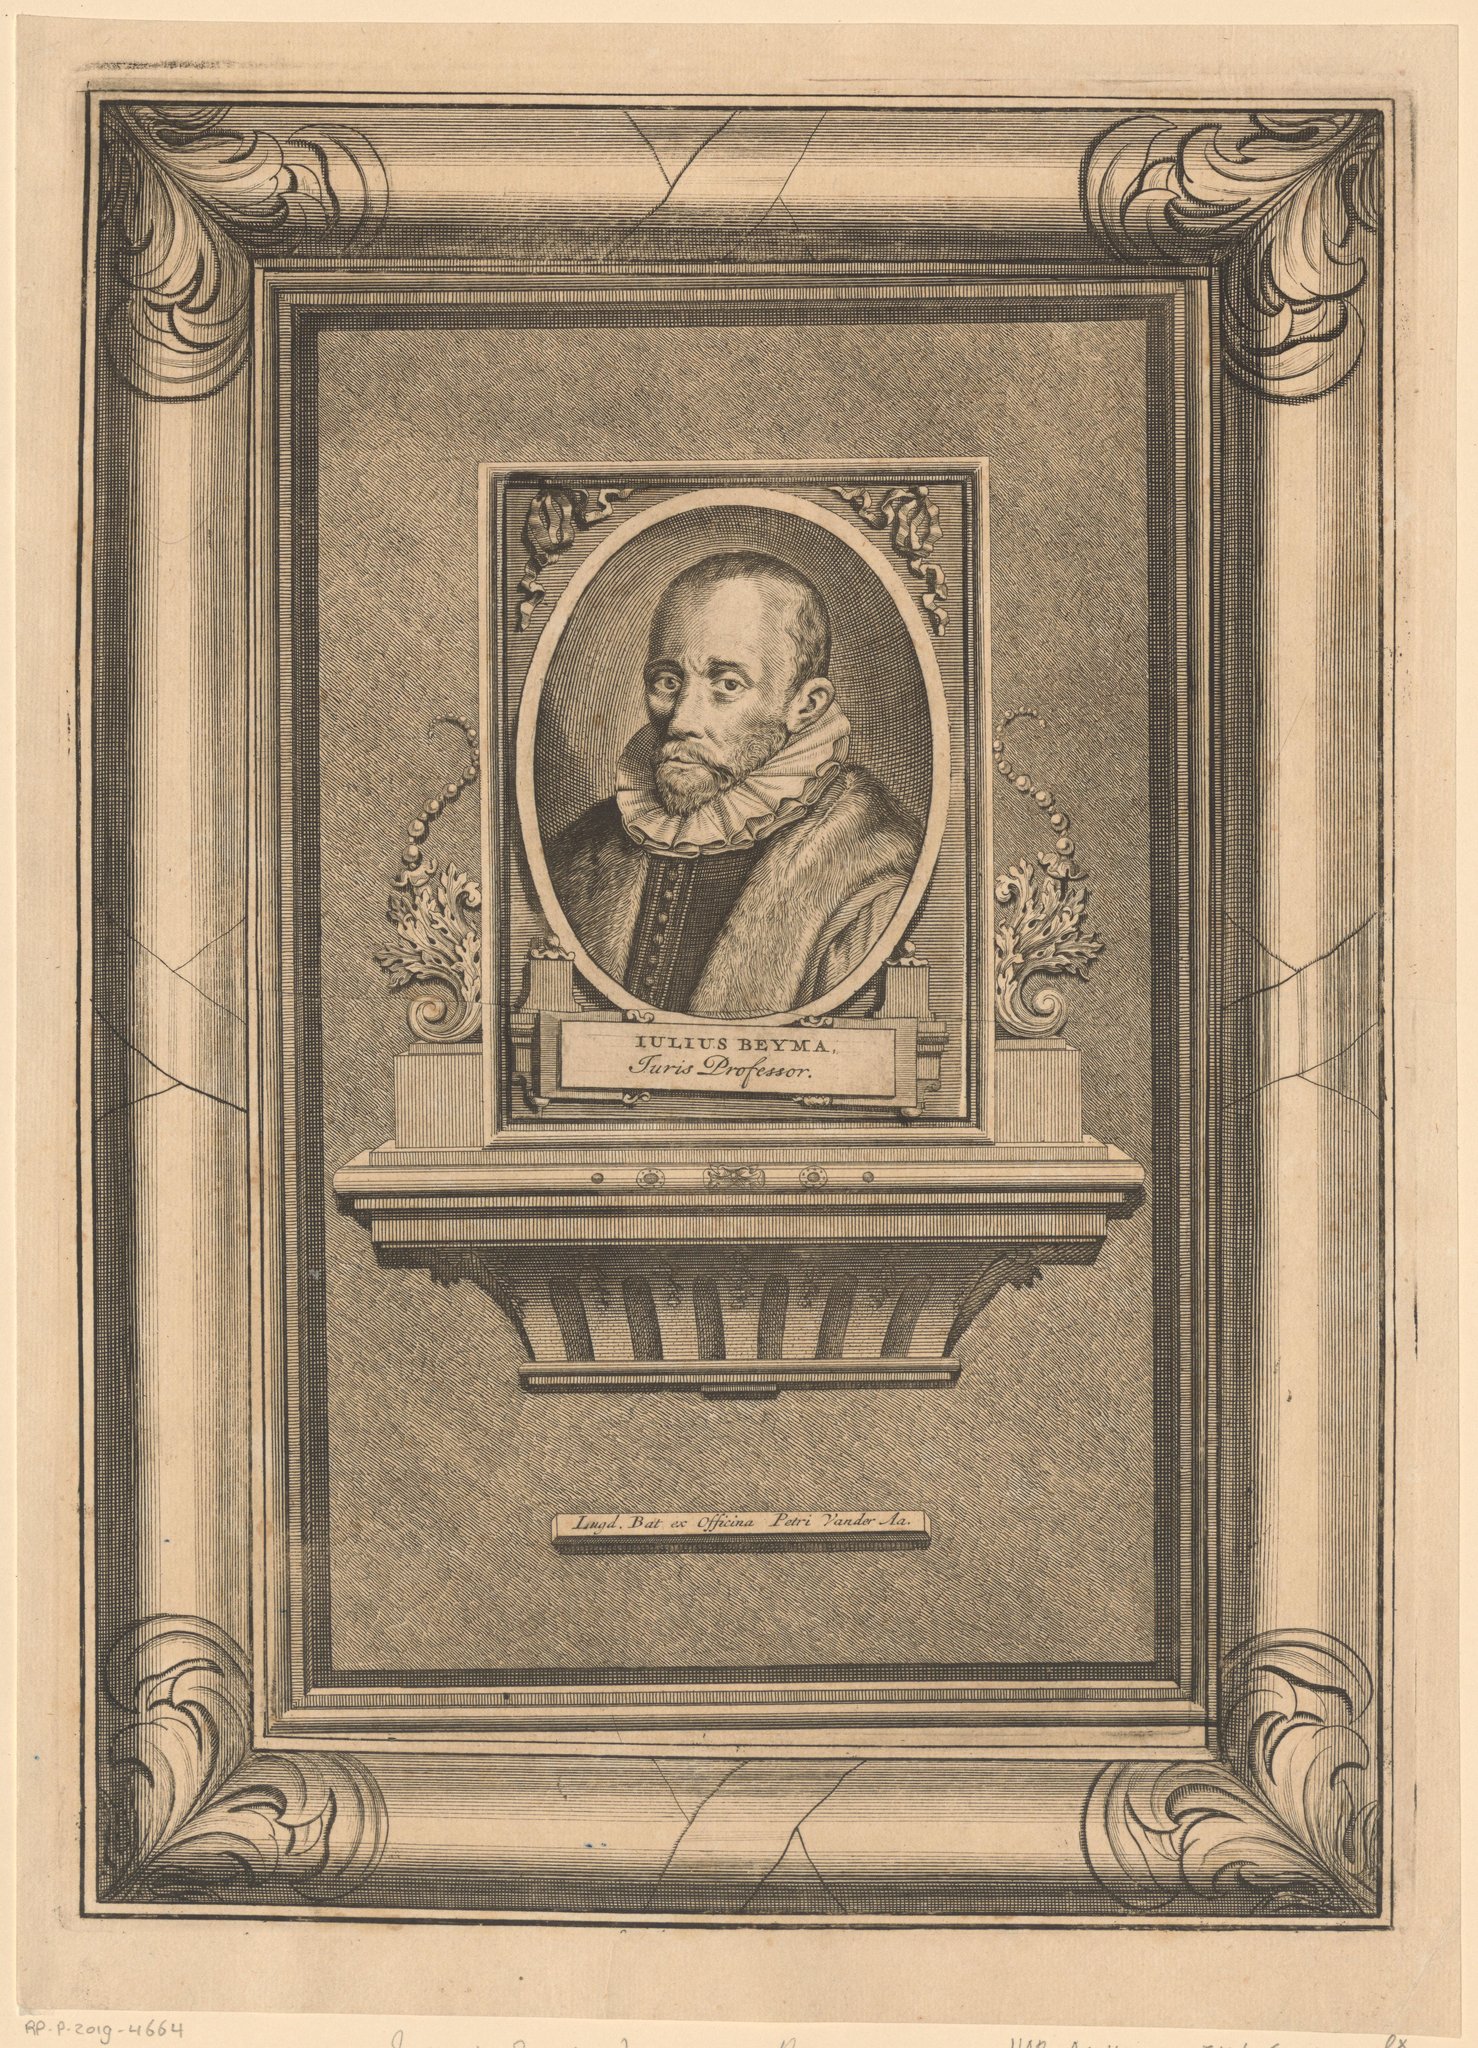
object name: print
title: Portret van Julius van Beyma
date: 1668-1733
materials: paper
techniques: engraving, etching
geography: leiden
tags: historical persons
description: Prent zonder dubbele omlijsting verschenen in: Fundatoris, curatorum et professorum celeberrimorum, aliorumque illustrium virorum, quorum gratia, favore cura, doctrinaque adademia Lugduno-Batava (...). Leiden: Pieter van der Aa, [ca. 1716].